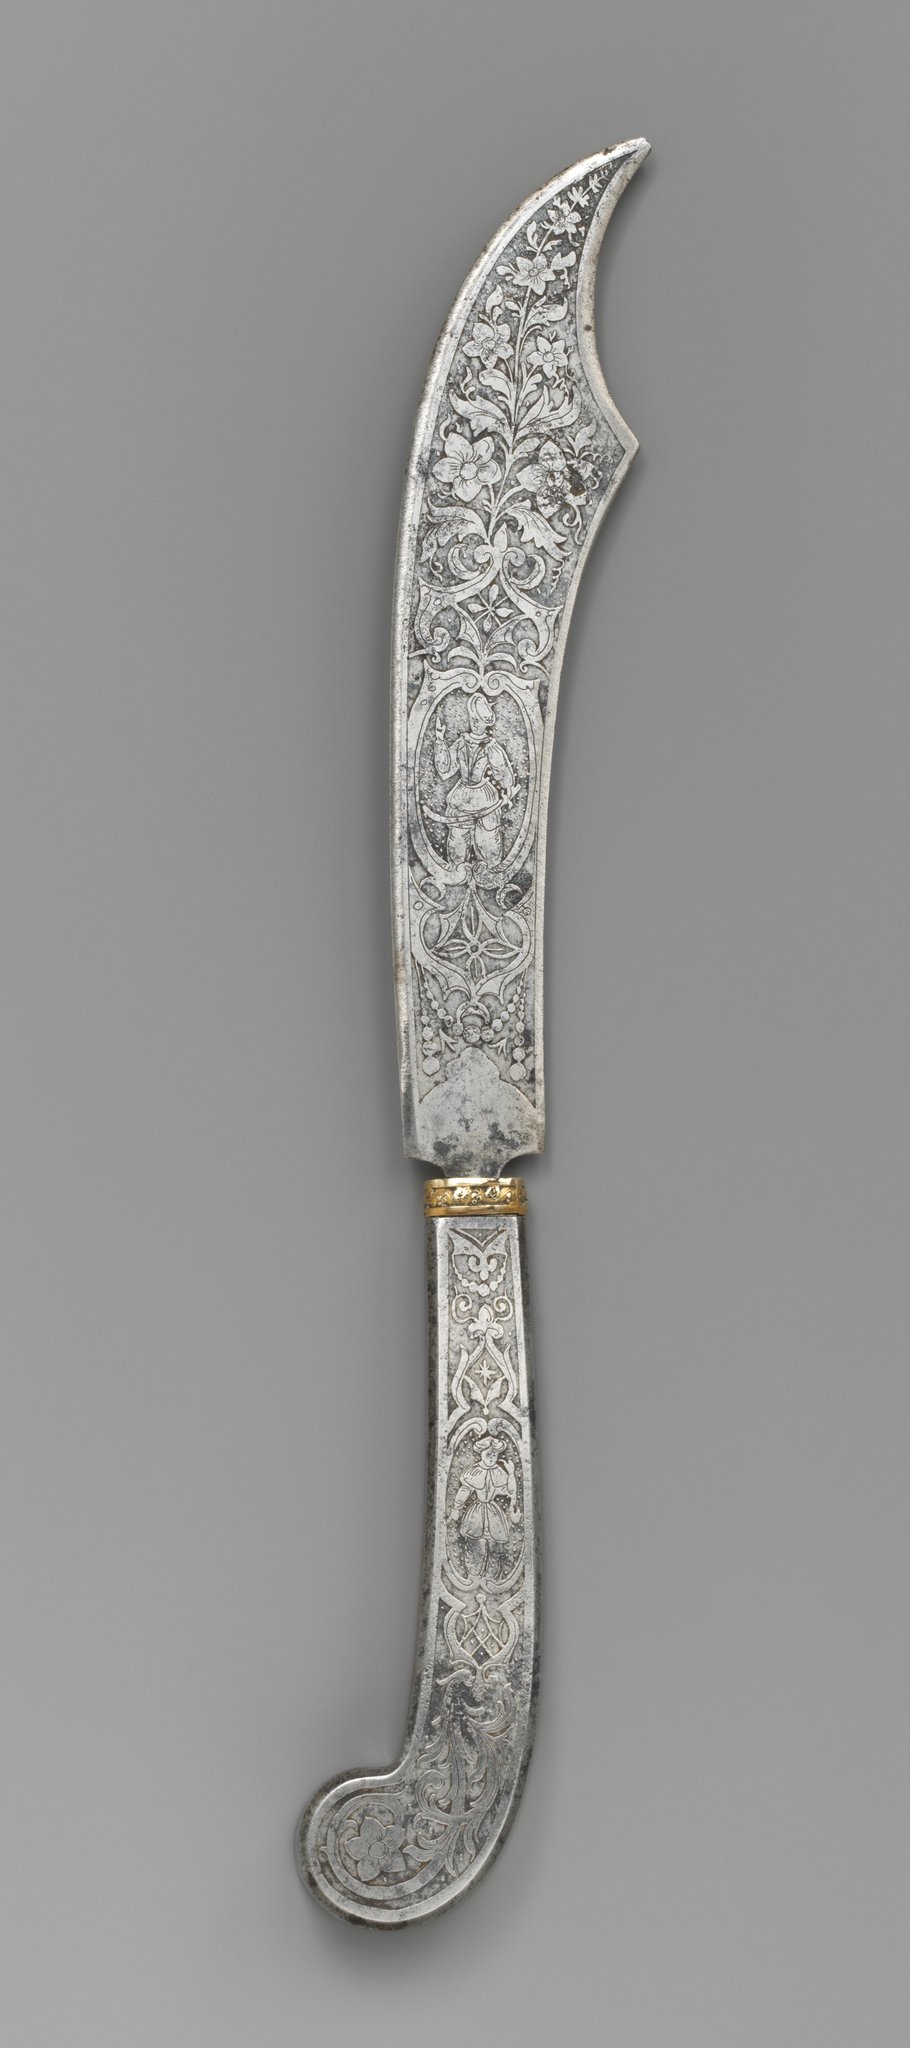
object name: letter opener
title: Letter opener with engraved figures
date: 1801-1900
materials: steel